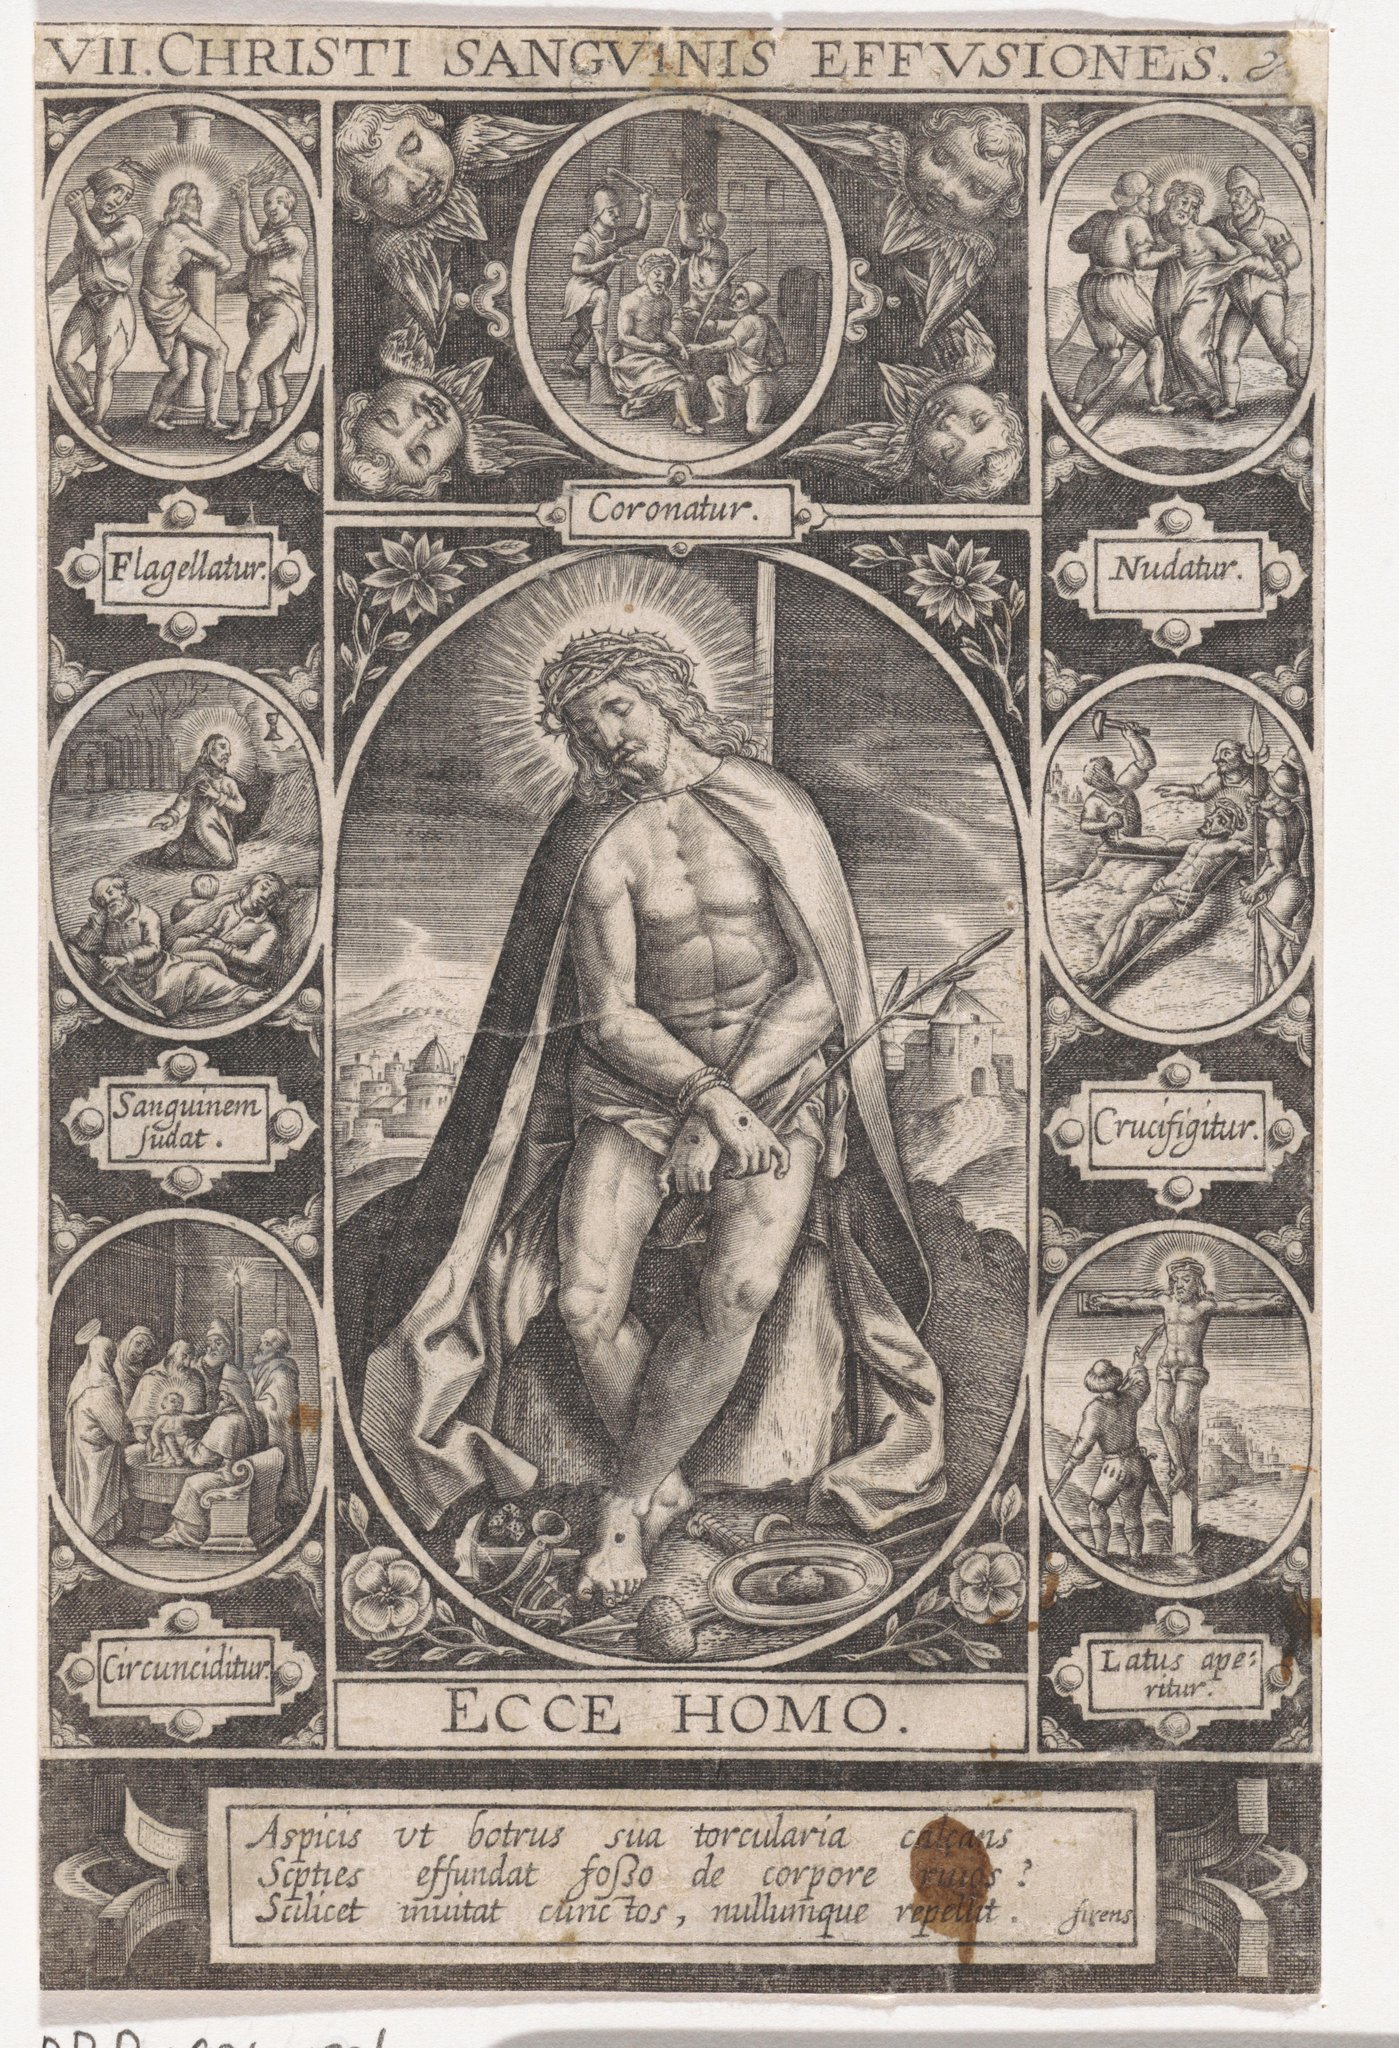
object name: print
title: VII. Christi Sangvinis Effvsiones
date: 1590-1638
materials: paper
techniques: engraving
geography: antwerp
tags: christ alone (also called 'ecce homo'), passion of christ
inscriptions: collector's mark: Lugt 2228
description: Christus als Ecce Homo: de geboeide Christus, met doornenkroon op het hoofd, en de rietstengel in de hand. Aan zijn voeten liggen de passiewerktuigen. De voorstelling is omringd door zeven scènes uit de passie van Christus. In het kader onderaan een drieregelig onderschrift in het Latijn.